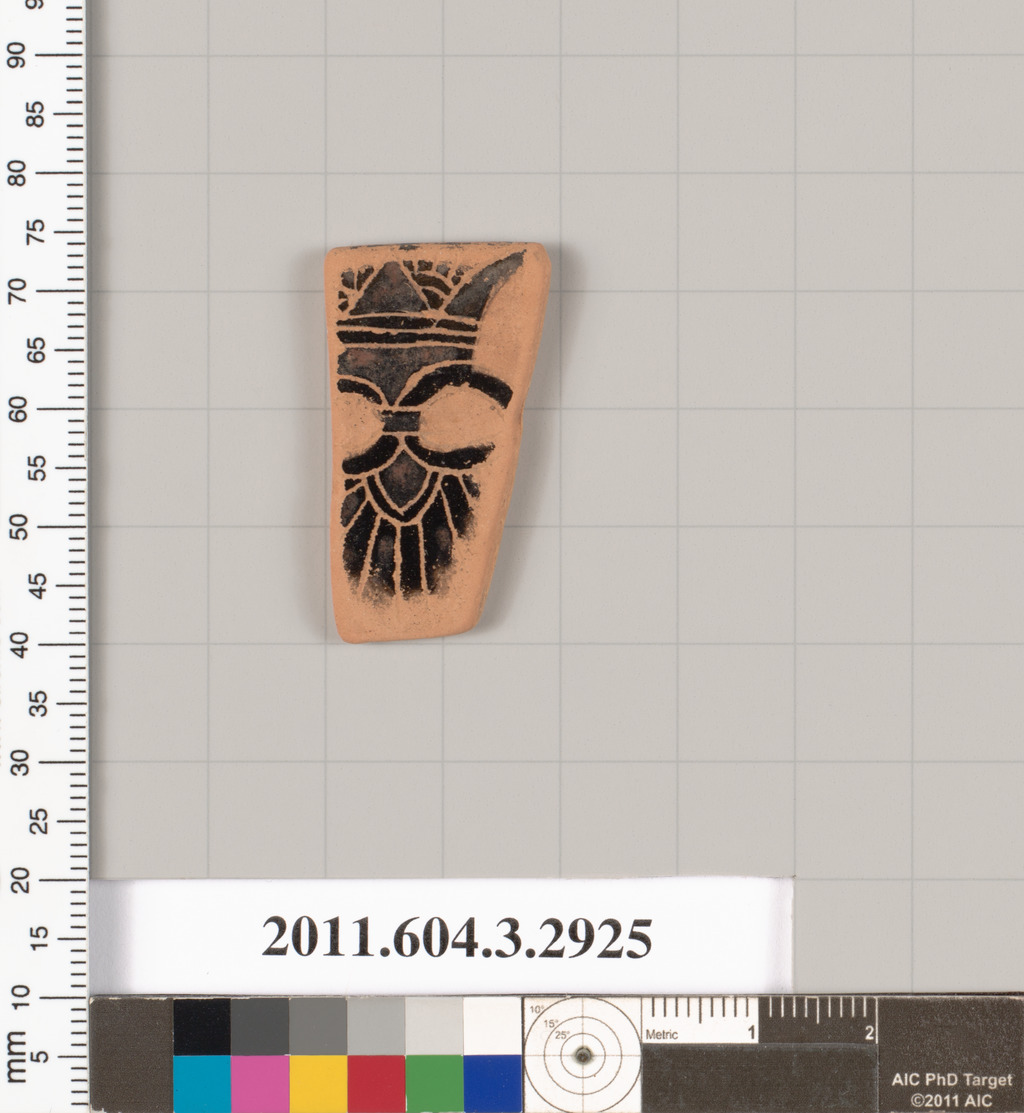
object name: undetermined shape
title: Terracotta fragment of an undetermined shape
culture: greek, attic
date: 575-551 BCE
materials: terracotta